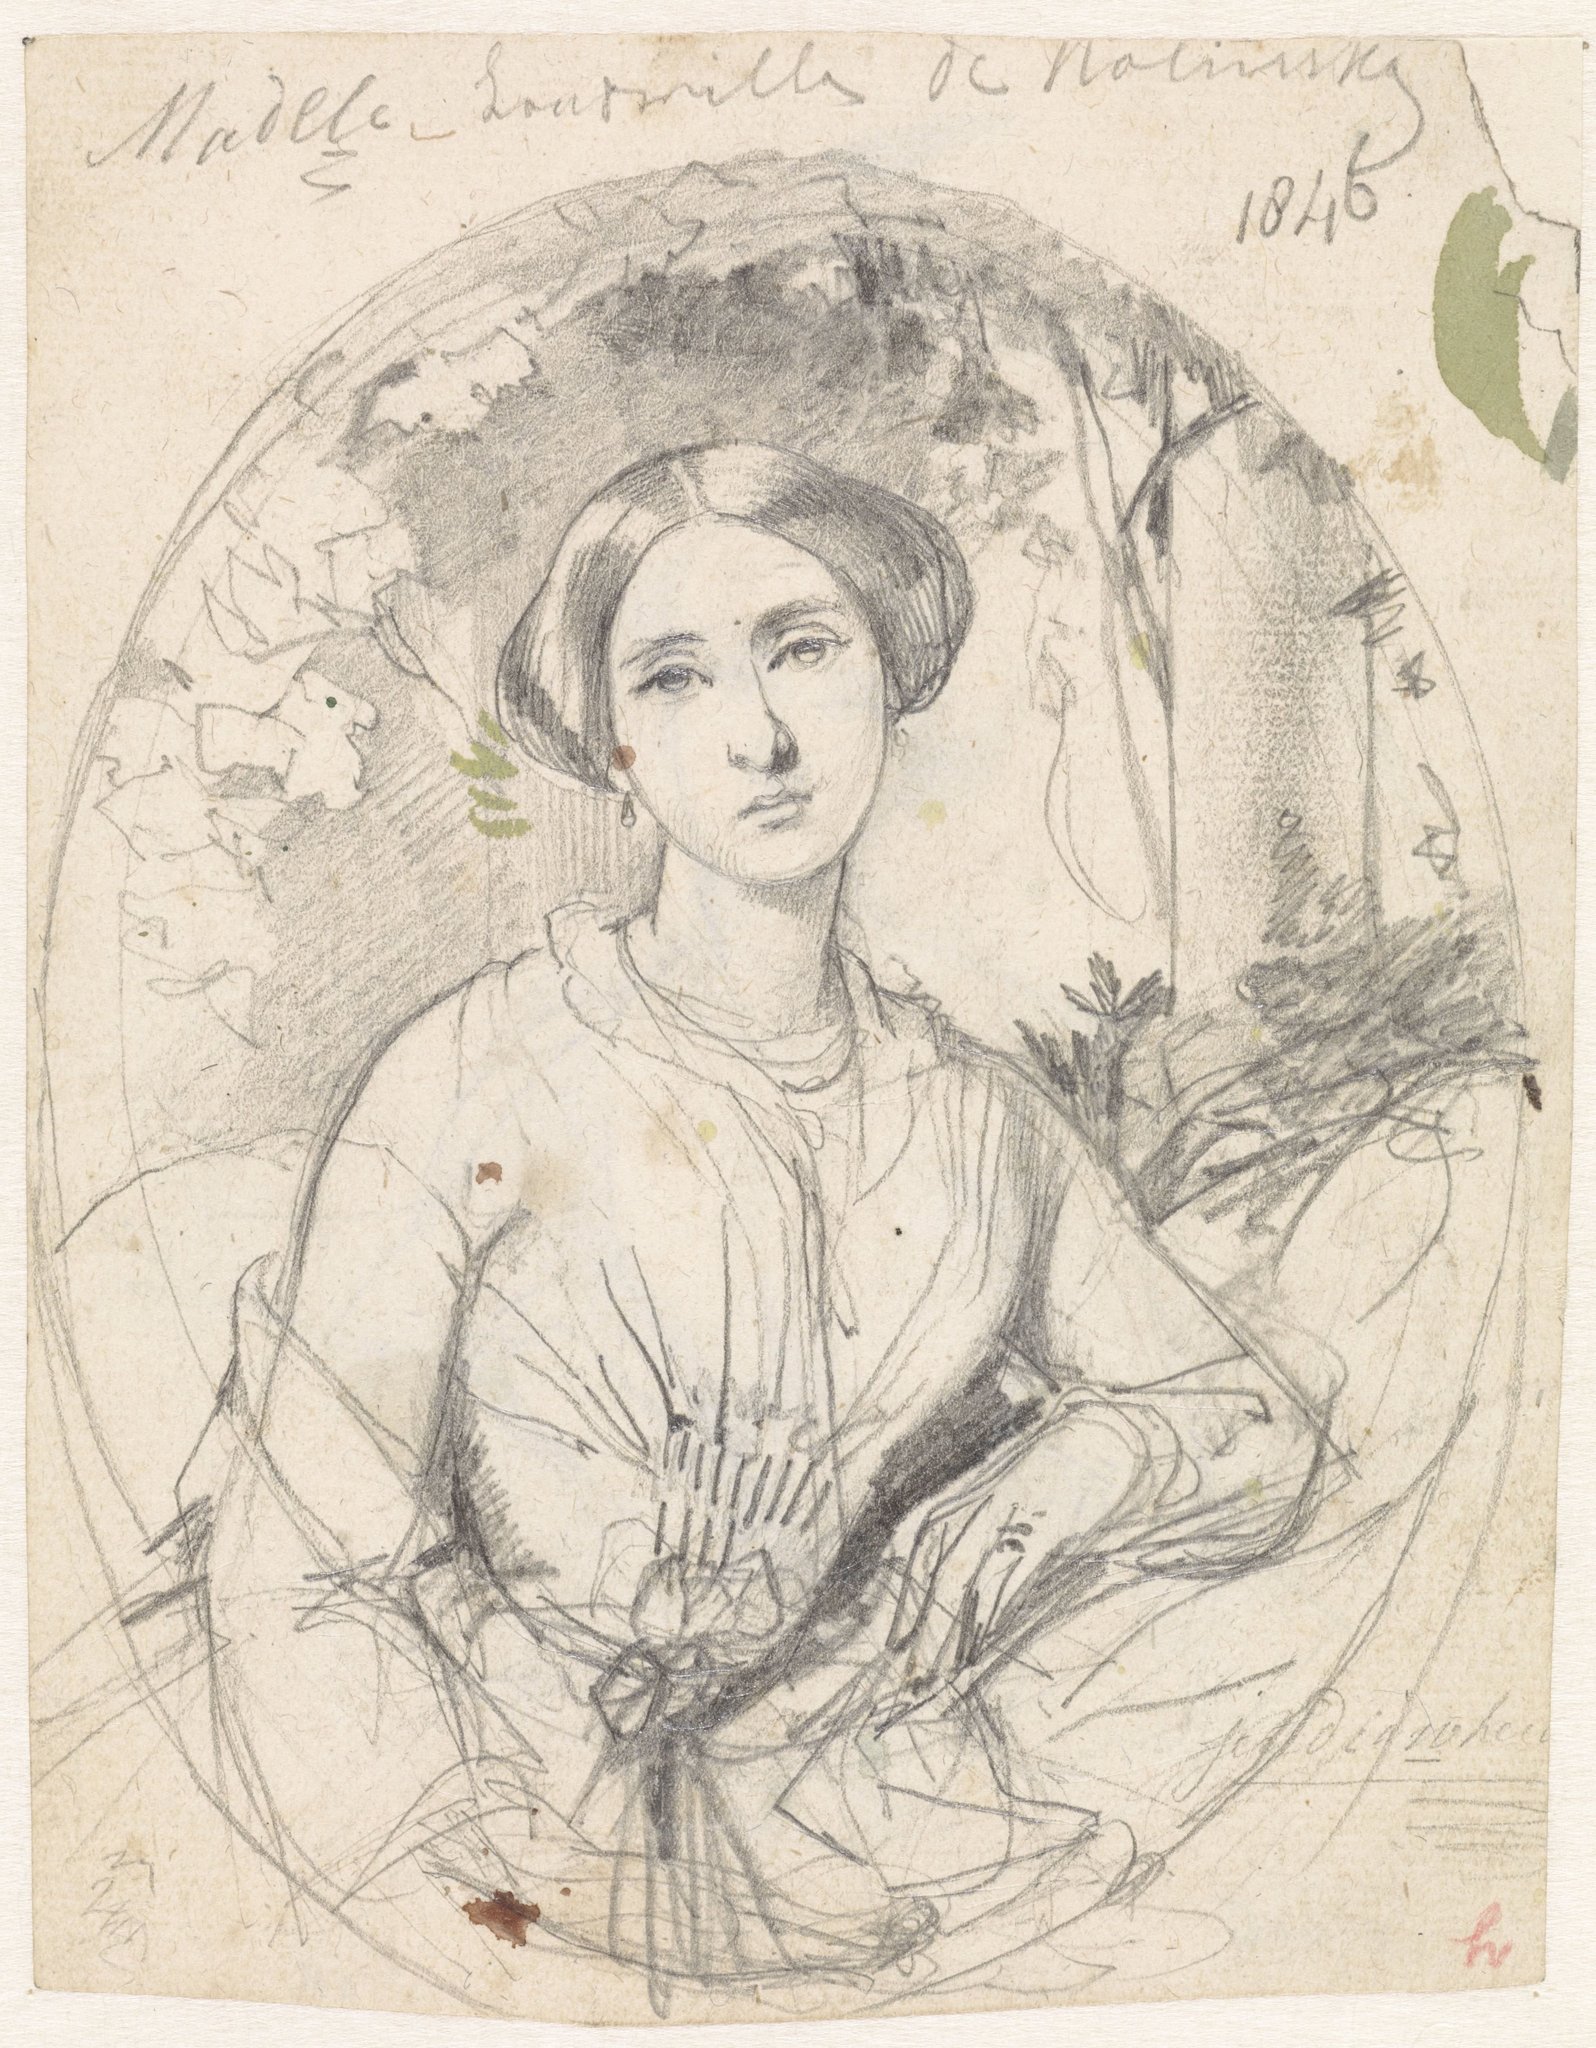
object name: drawing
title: Portret van Ludmilla de Nolinsky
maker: johan hendrik koelman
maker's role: draughtsman, print maker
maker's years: 1820-1887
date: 1846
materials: paper, pencil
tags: historical persons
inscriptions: date: ‘1846’